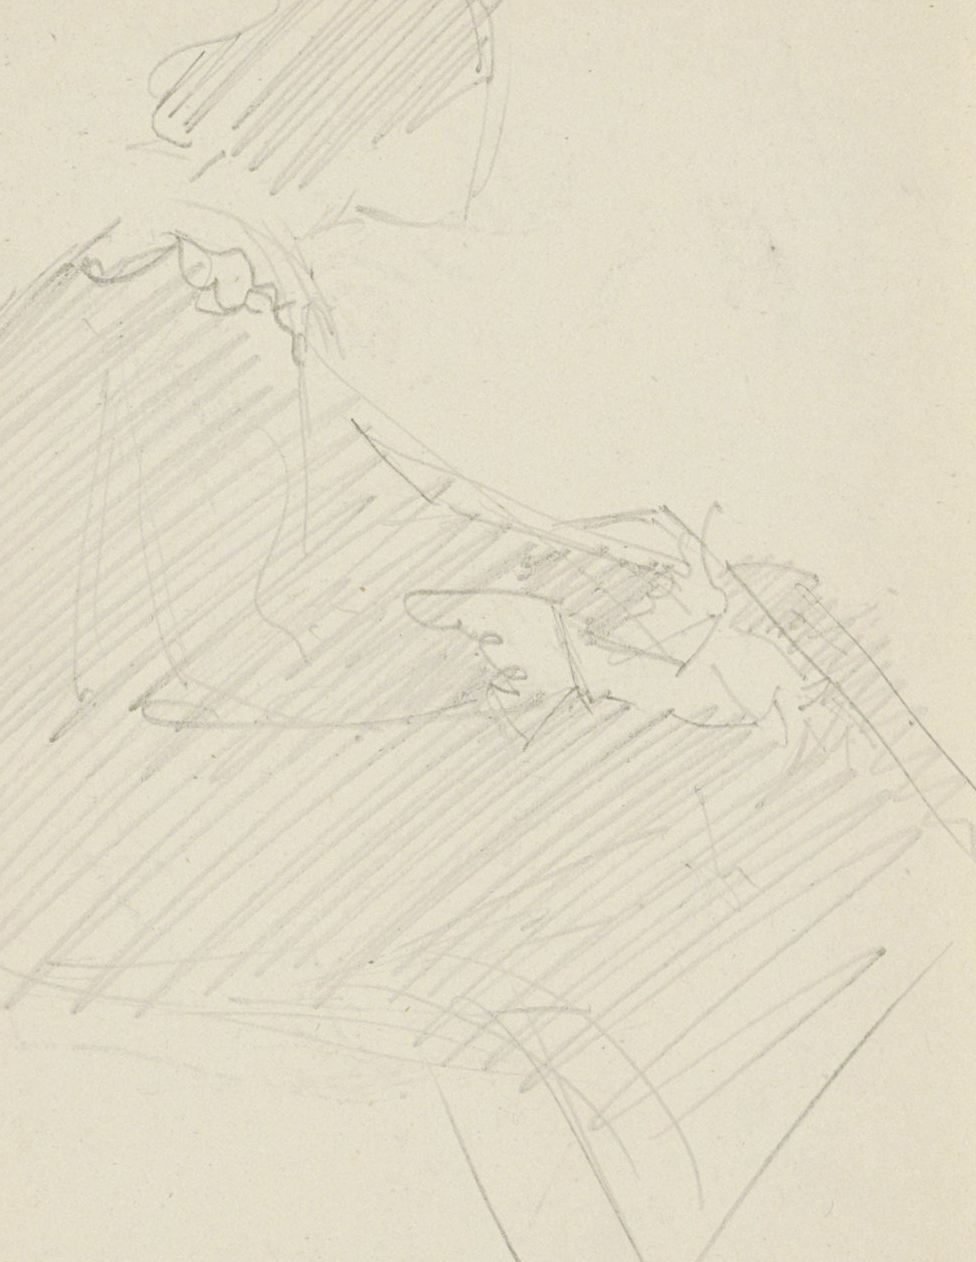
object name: sketchbook leaf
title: Zittende vrouw in profiel naar rechts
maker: reijer stolk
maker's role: draughtsman, print maker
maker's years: 1896-1945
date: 1906-1945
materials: paper, pencil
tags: sitting figure - aa - female human figure (+ right side visible; right - (r. hand, r. foot, etc.))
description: Blad 63 verso uit een schetsboek met 69 bladen.